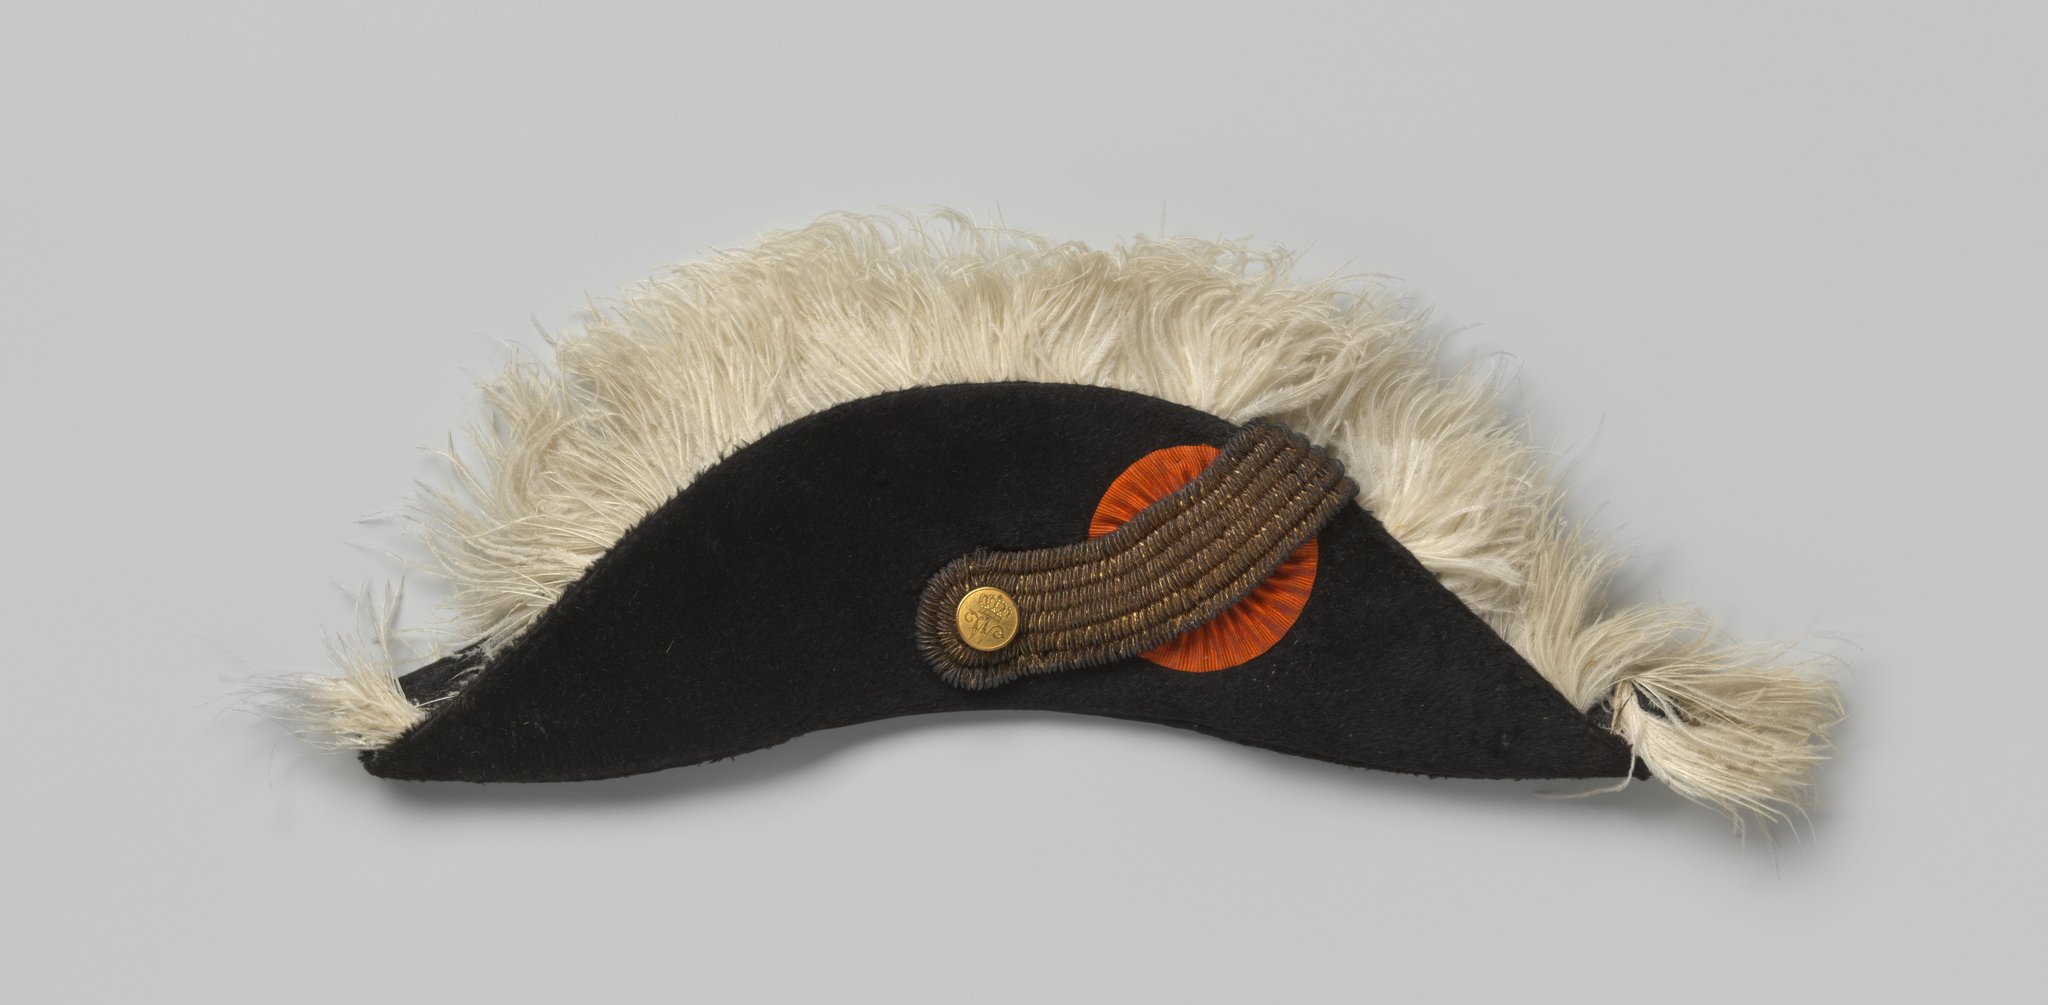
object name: ambtskostuum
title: Steek van ambtskostuum van Hendrikus Colijn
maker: Anonymous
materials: feather, gold, gold thread, silk, wool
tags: hendrikus colijn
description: H. Colijn's ministerial uniform and sabre. Sabre of silver and ivory, sheath of nickel-plated steel. Hendrikus Colijn (1869-1944) began his career as a soldier in the Dutch East Indies. As a veteran of the 1894 Lombok campaign he was awarded the Militaire Willemsorde. In 1899, following his participation in the Atjeh campaign, he was presented with this honourary sabre. In 1904 he was appointed adjutant to Governor General Van Heutsz. Back in the Netherlands (1909), Colijn entered parliament as an Anti-Revolutionary (1909-1911). He served as minister of war (1911-1913), head of the Bataafsche Petroleum Maatschappij (1914-1922), minister of finance (1923-1925) and prime minister (1925 and 1933-1939). His drastic economic cuts during the Depression met with deep resentment. Although not the original decorations, these are identical to those awarded to Colijn.